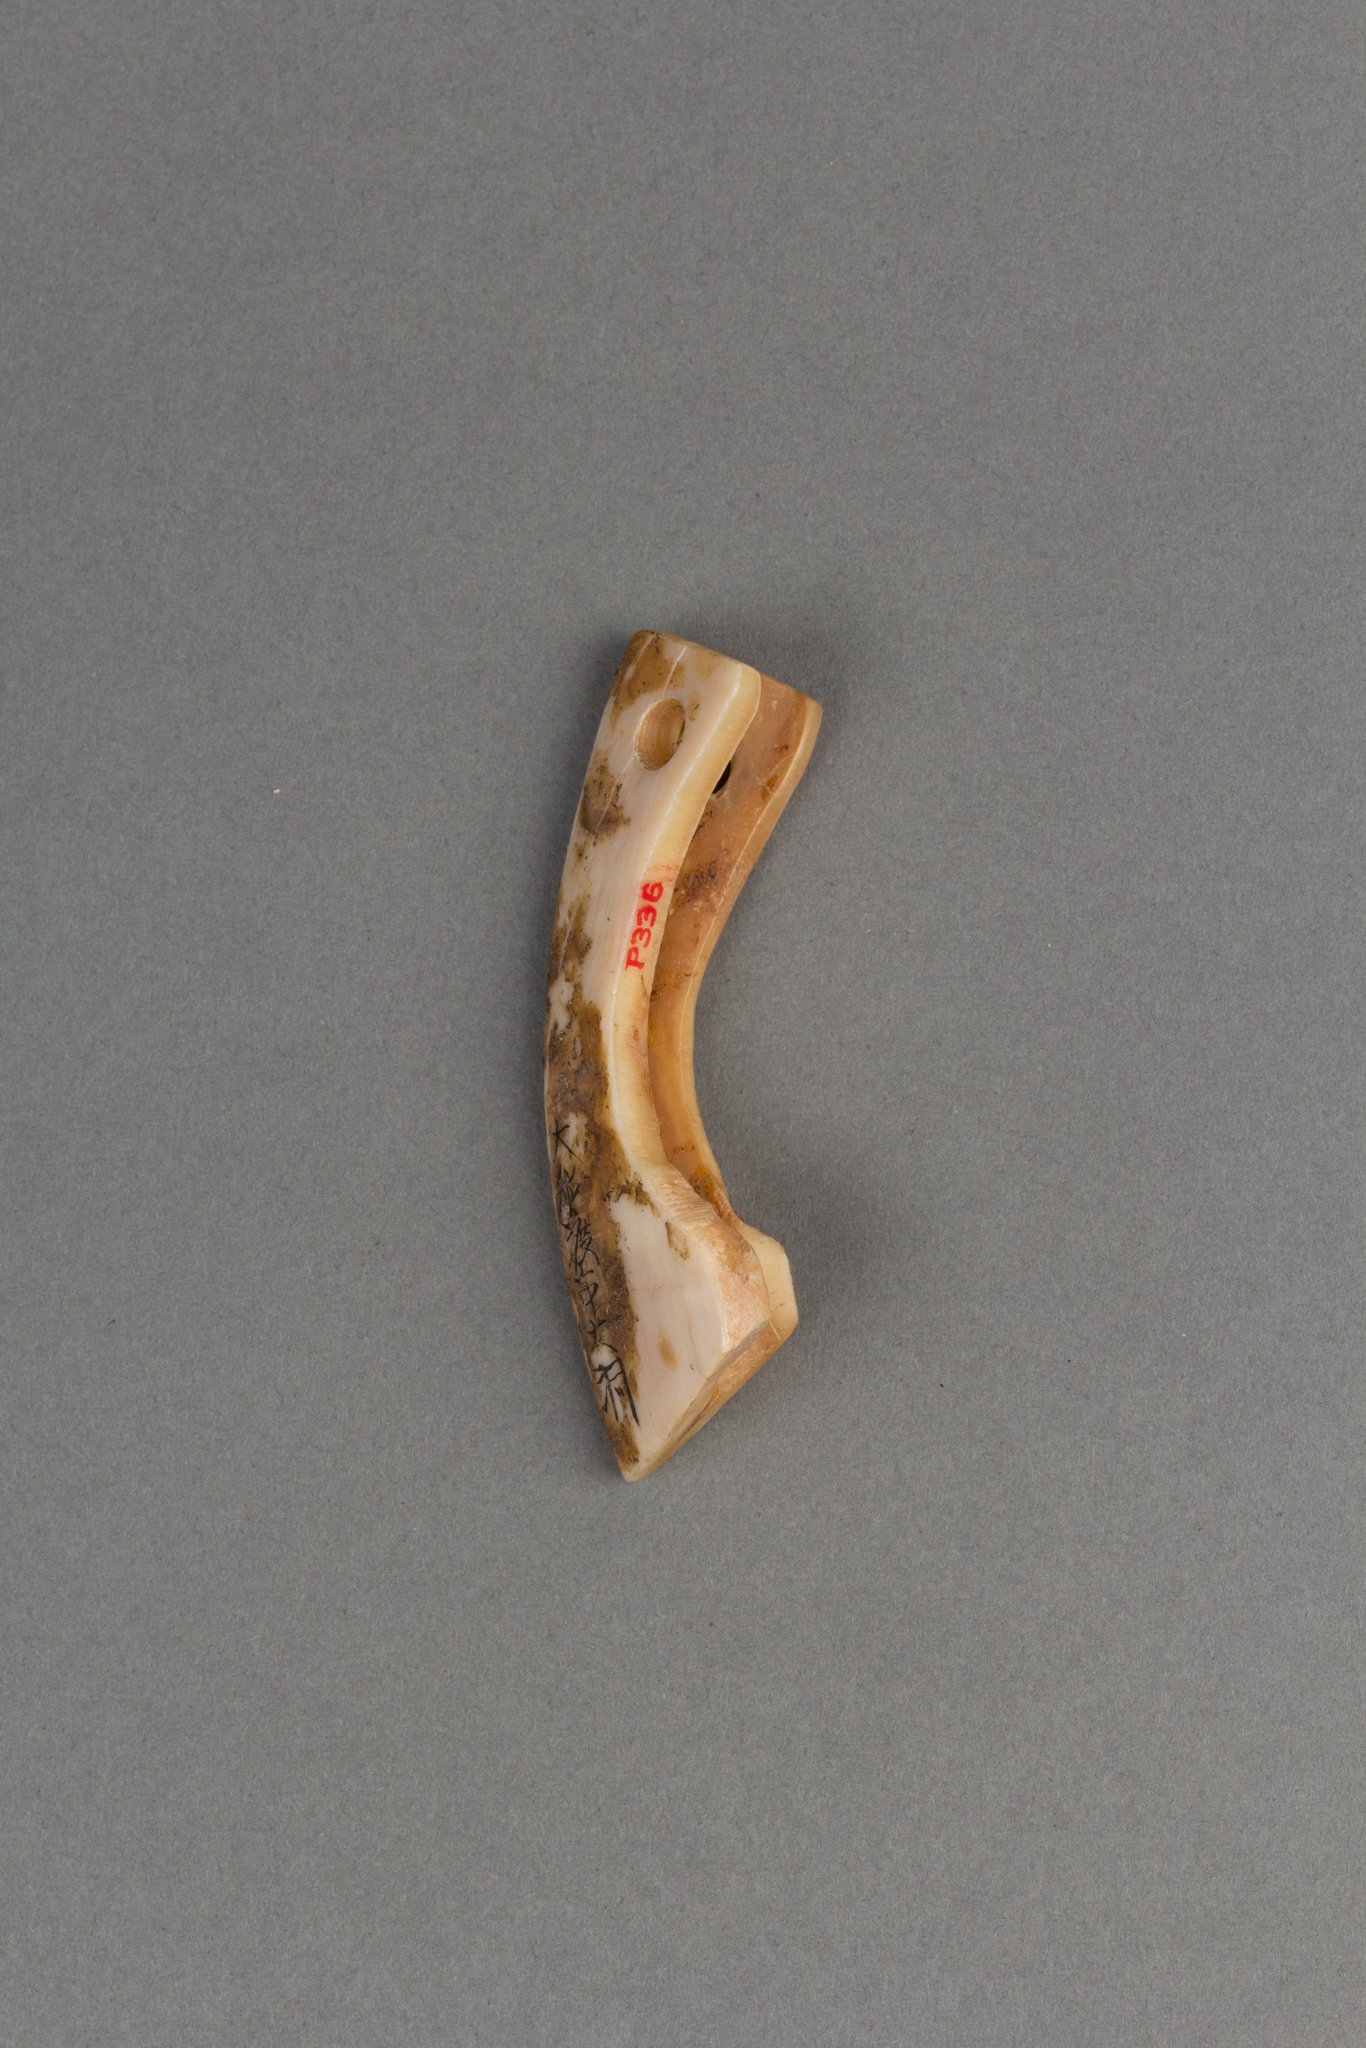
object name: arrowhead, needle, hook and harpoon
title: Arrowheads, needles, hooks and harpoons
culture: japanese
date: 1200-200 BCE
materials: bone